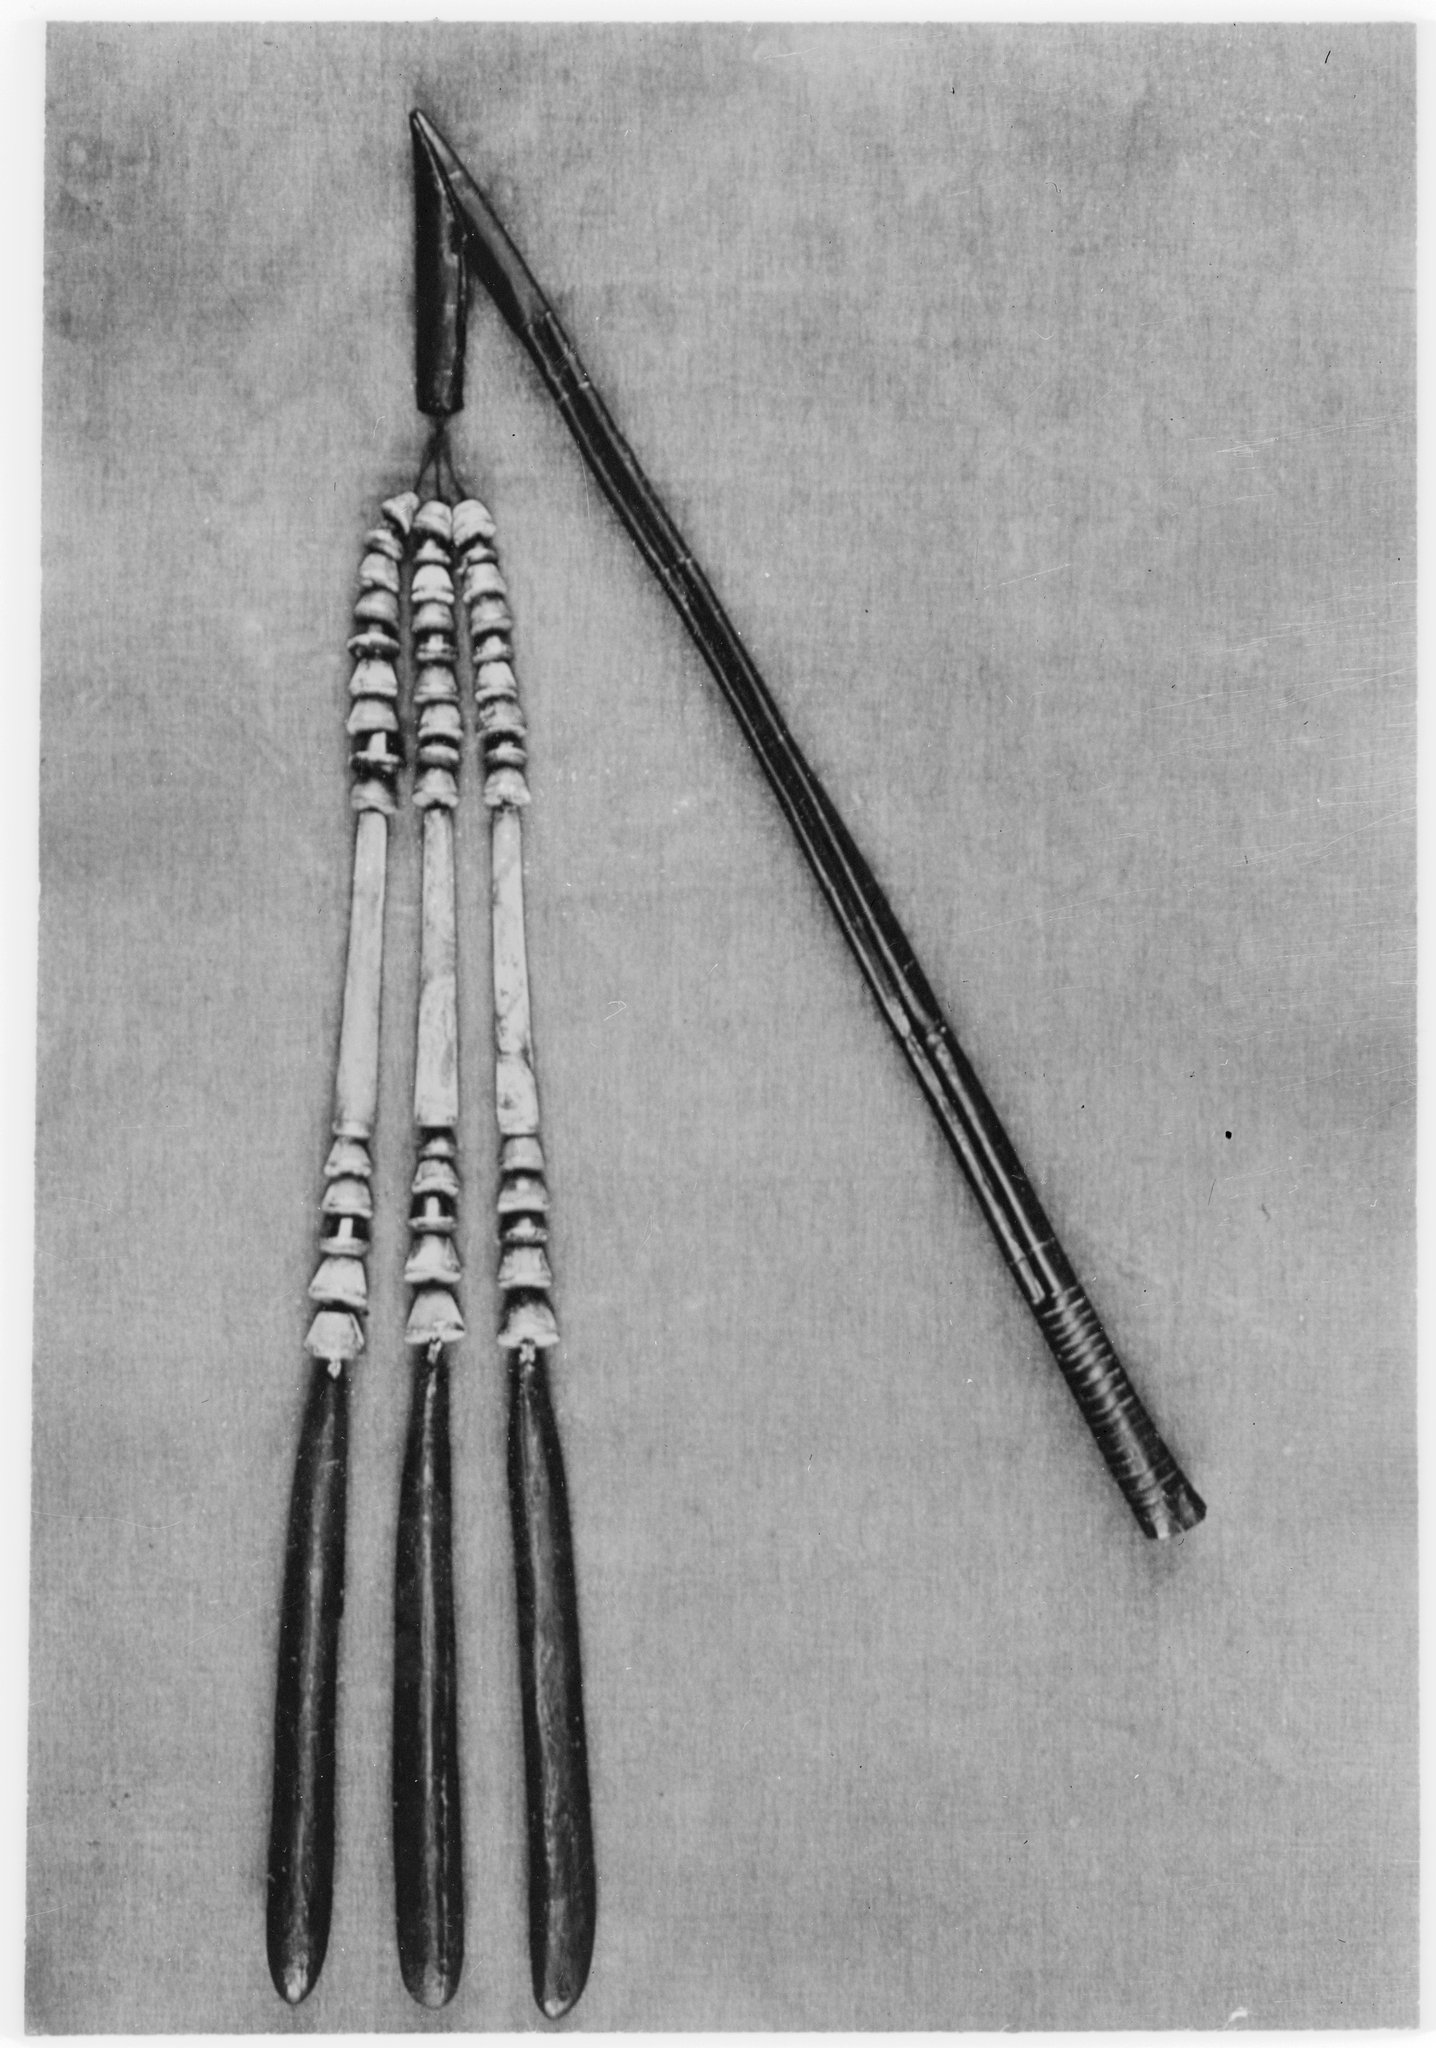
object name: scepter, senebtisi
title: Flail scepter from the tomb of Senebtisi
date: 1850-1775 BCE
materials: gemstone, faience, gold, paint, wood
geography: egypt